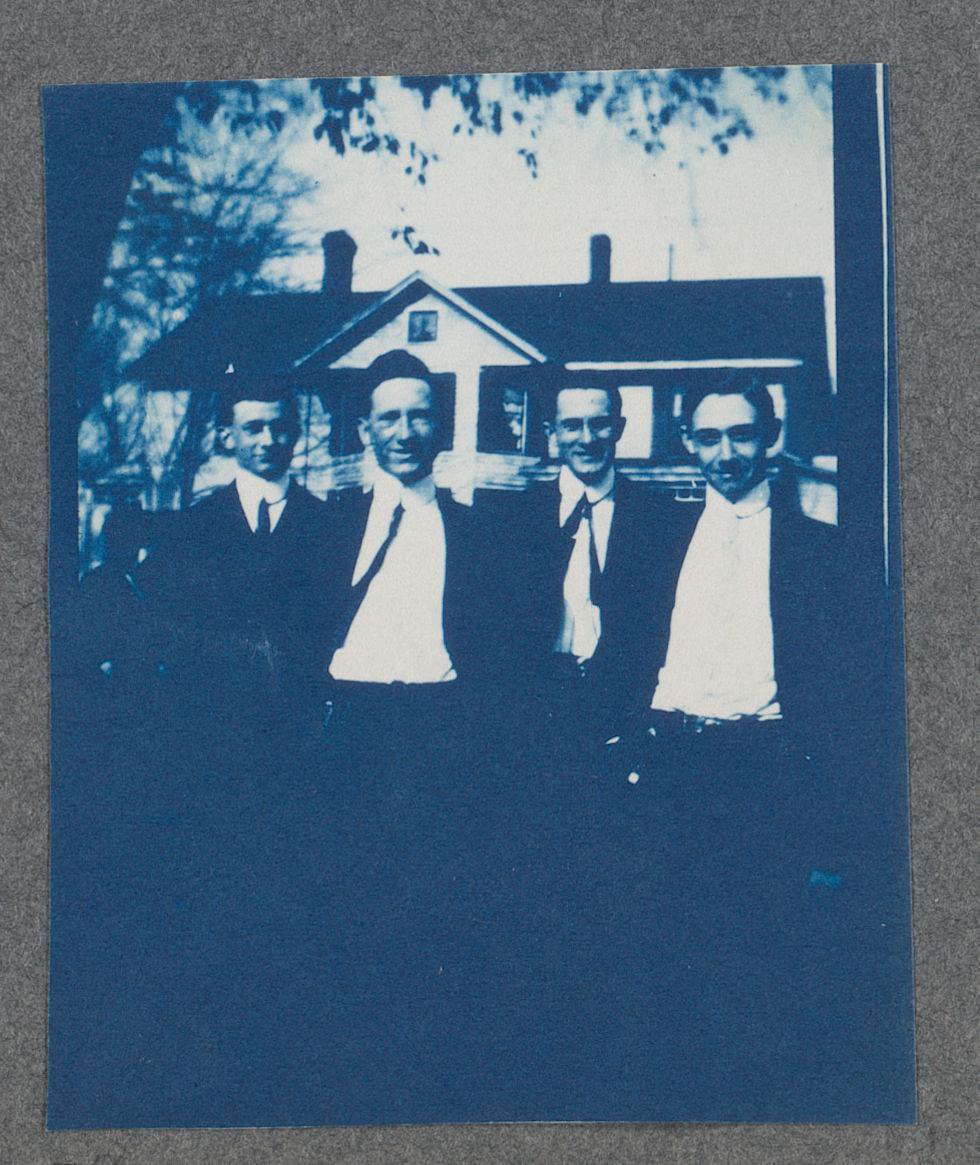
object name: photograph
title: Vier jonge mannen, mogelijk op de schoolcampus van St. Johnsbury Academy in Vermont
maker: Anonymous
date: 1905-1915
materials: paper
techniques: cyanotype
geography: st. johnsbury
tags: student